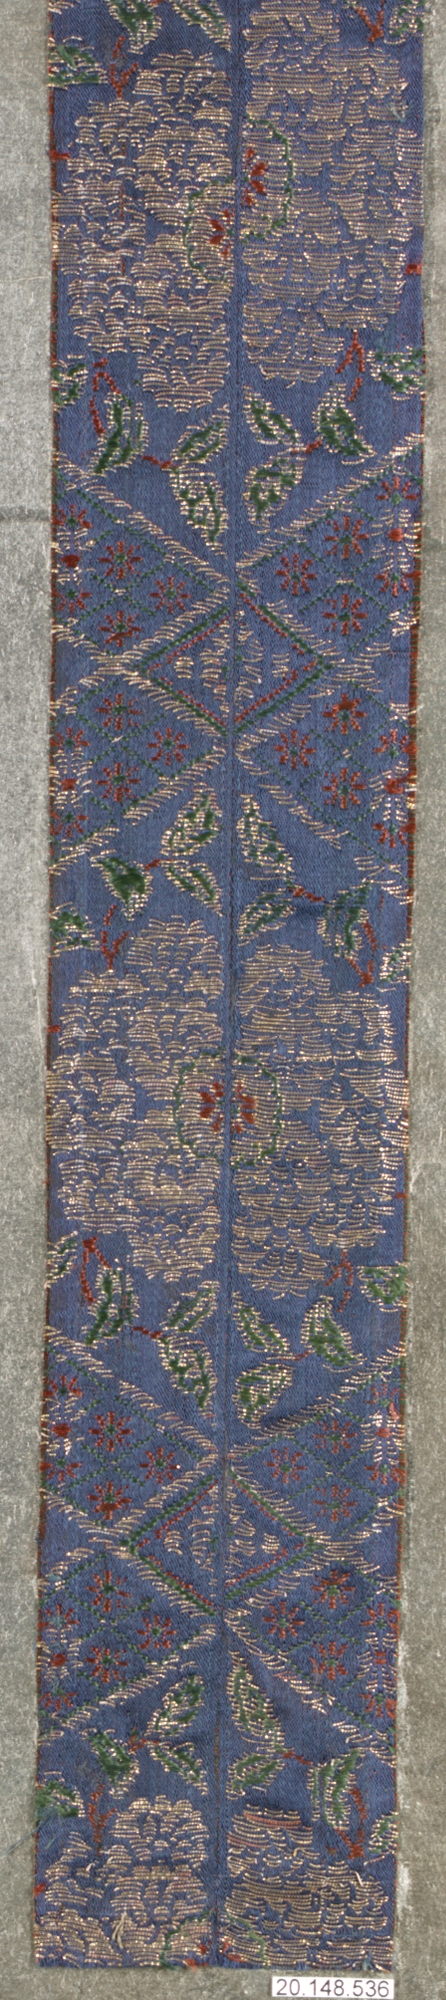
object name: piece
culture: japanese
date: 1701-1800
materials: silk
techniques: compound weave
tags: flowers,leaves